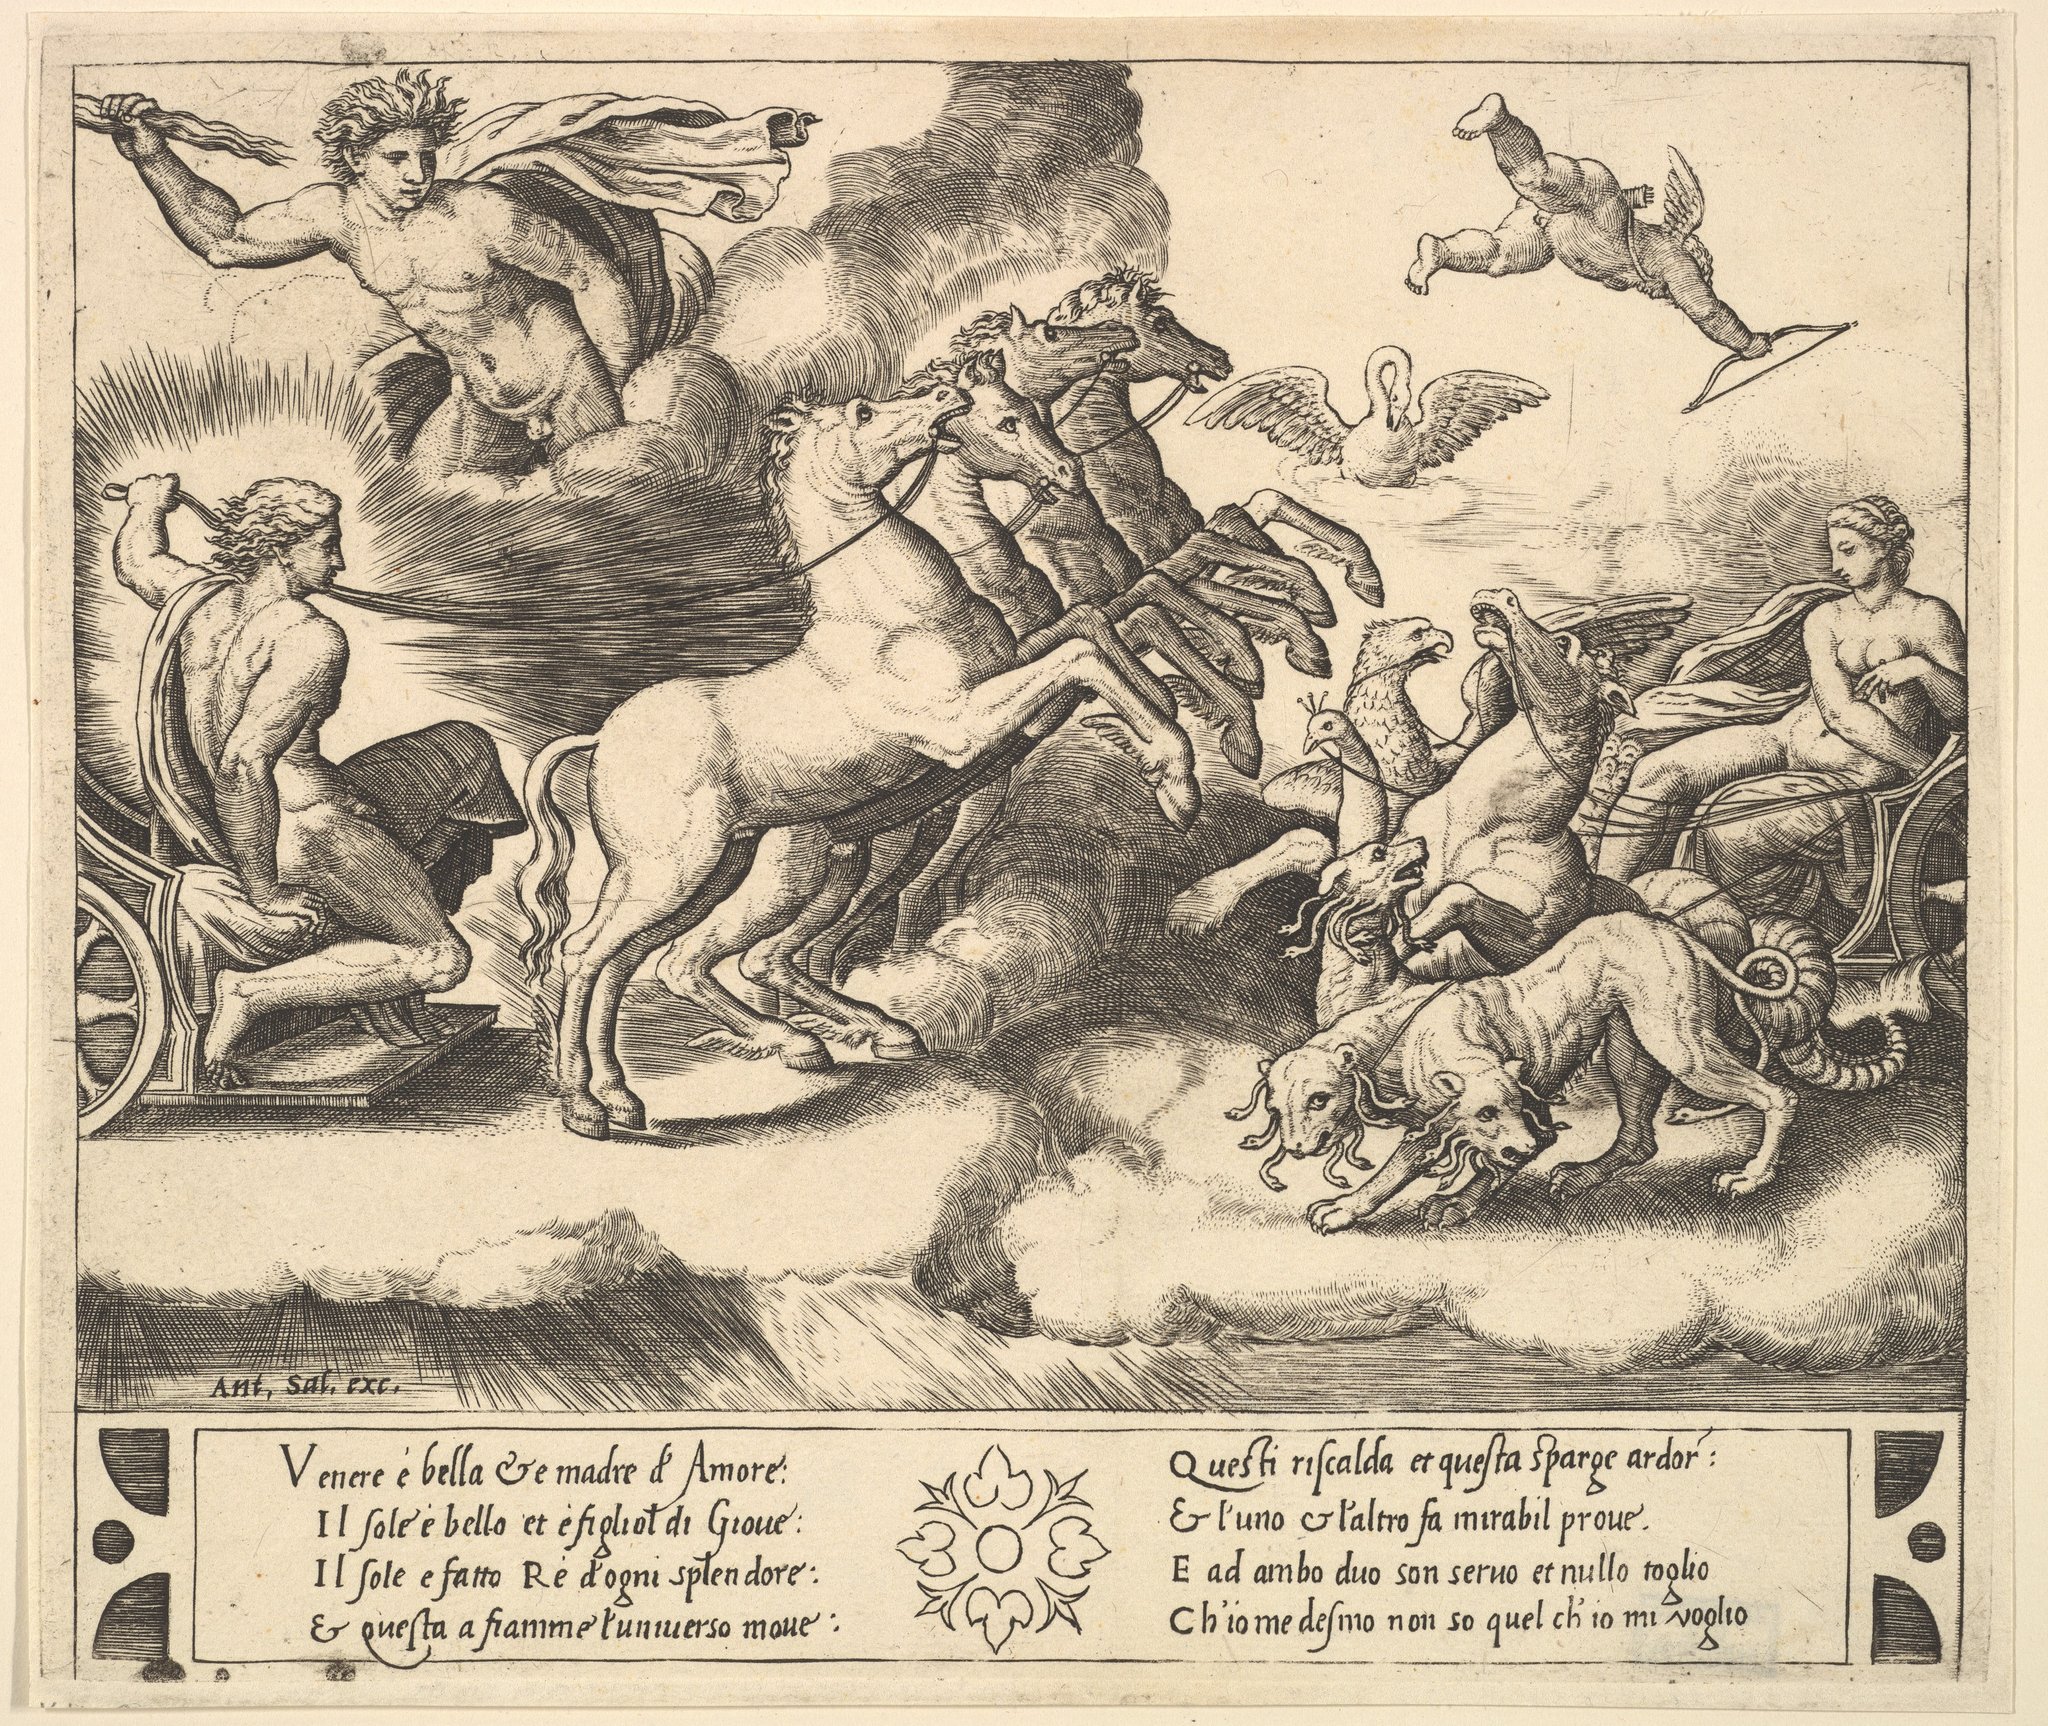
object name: print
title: Apollo in his horse-drawn chariot at the left, above him above Jupiter hurls a thunderbolt, Venus at right in her chariot drawn by animals, from "Story of Apollo and Daphne"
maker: master of the die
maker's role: artist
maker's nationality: italian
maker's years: 1525-1560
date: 1530-1560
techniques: engraving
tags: apollo,jupiter,venus,horses,chariots